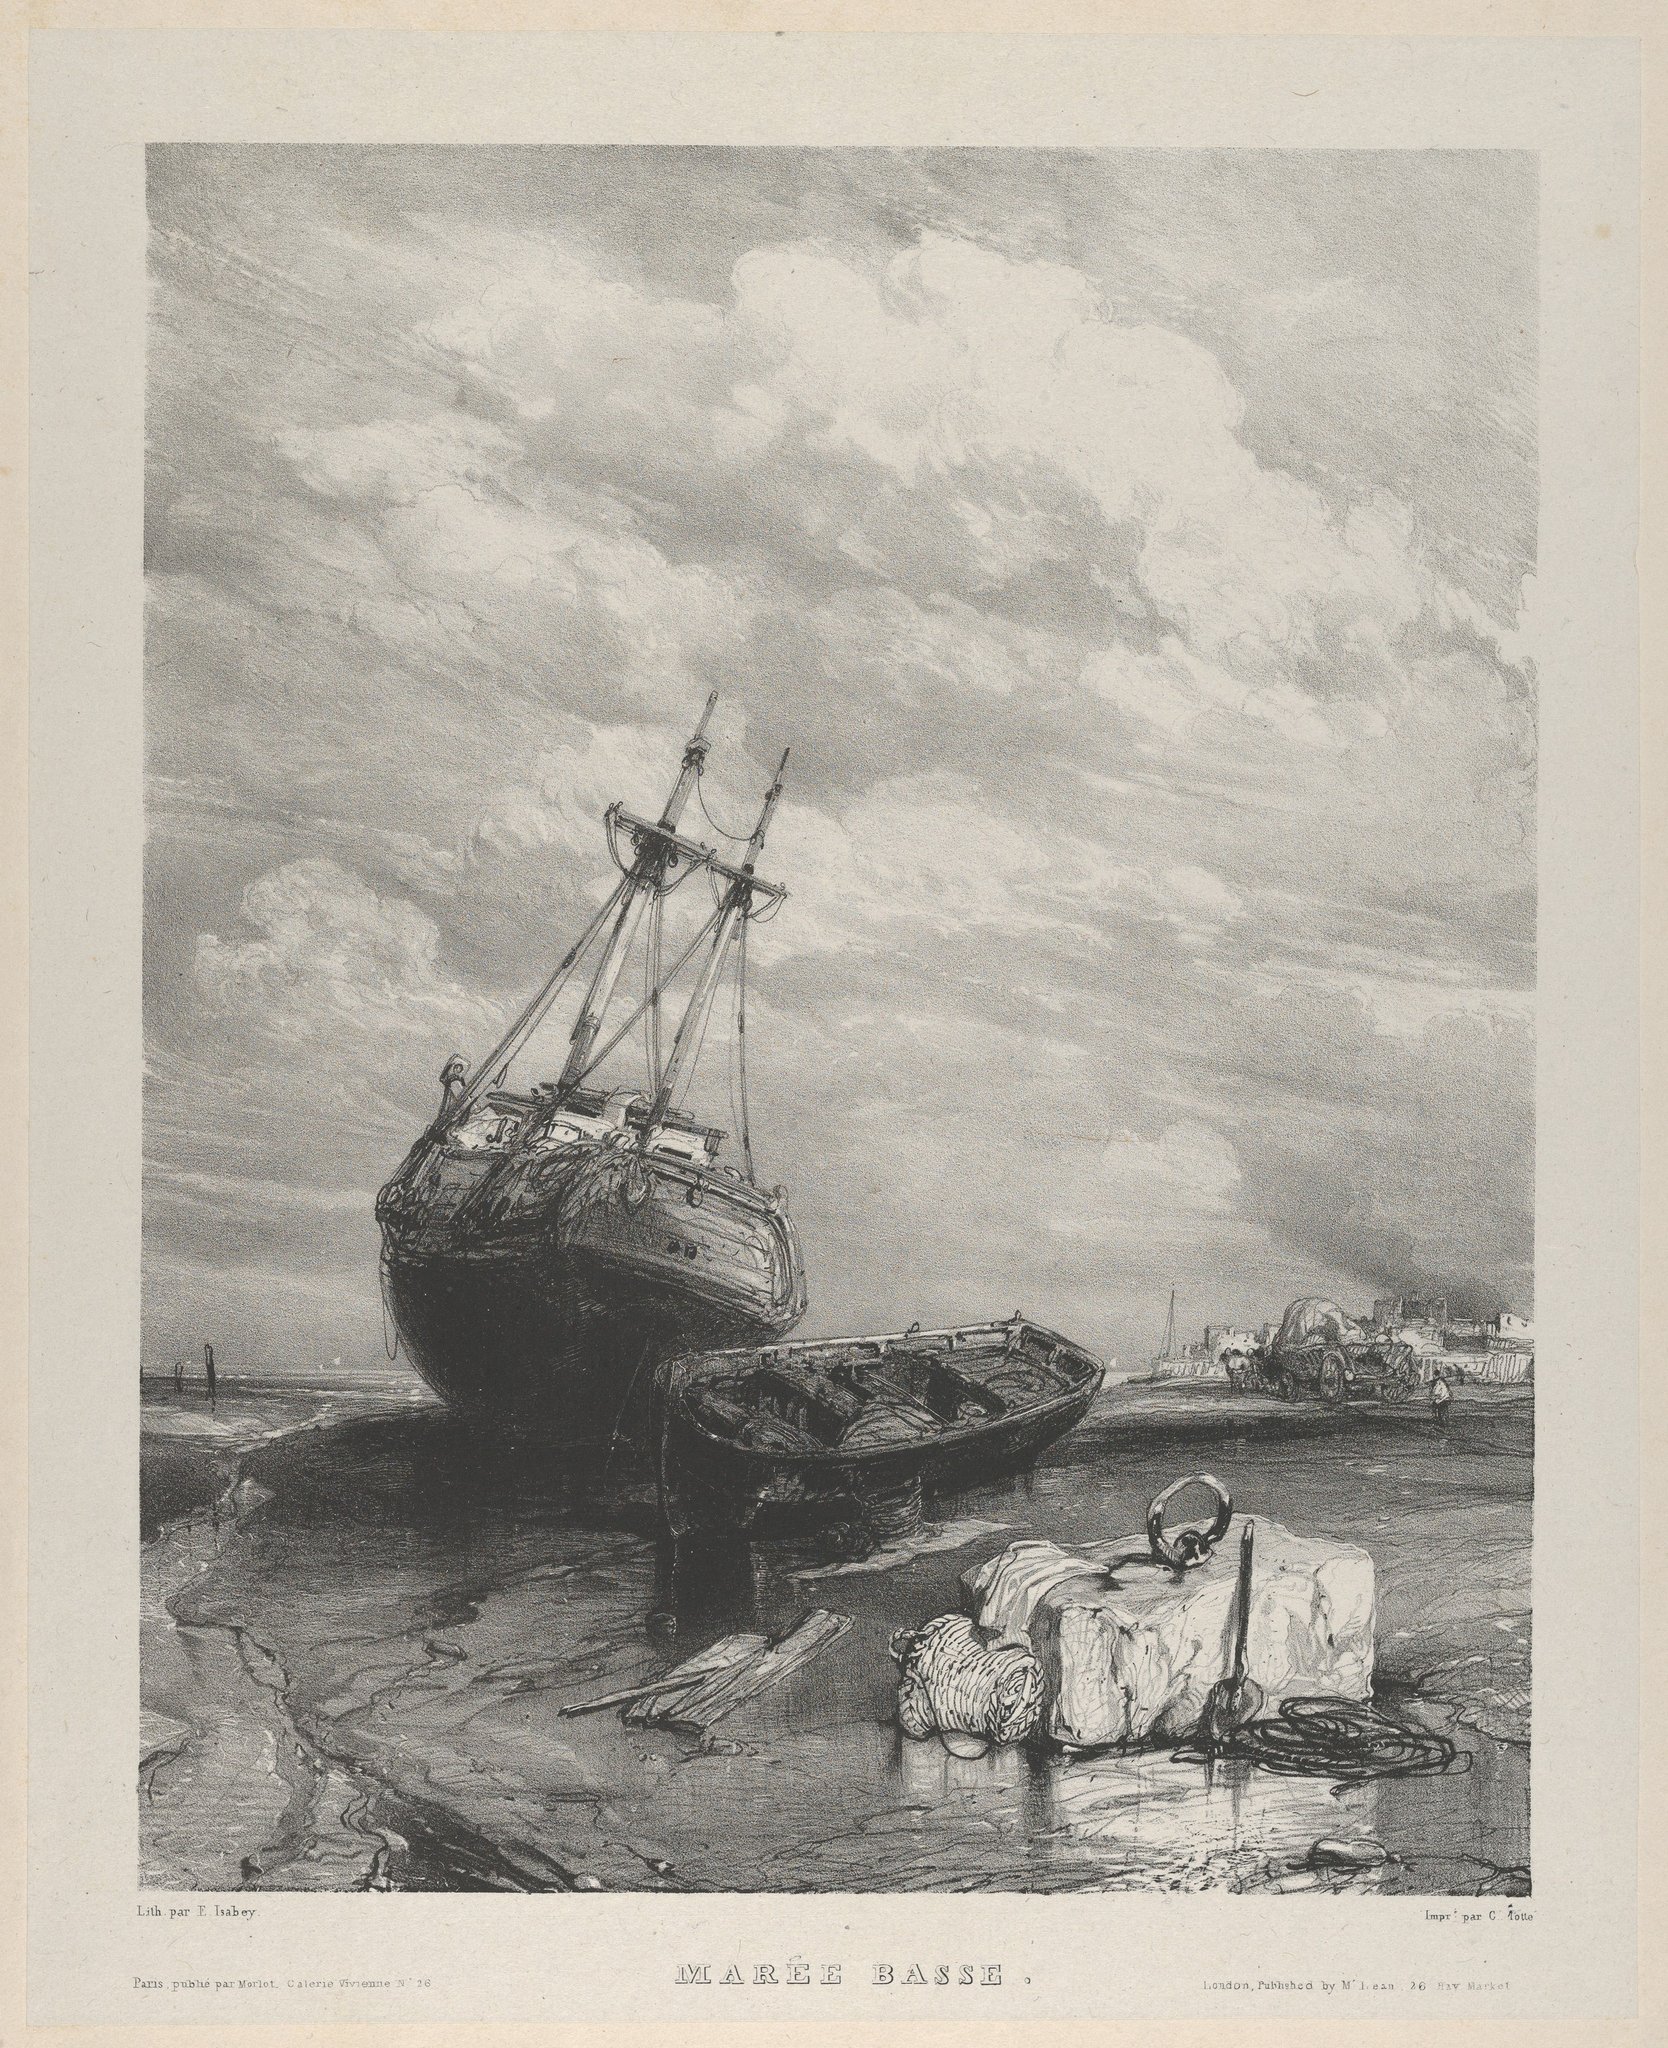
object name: print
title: Low Tide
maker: eugène isabey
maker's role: artist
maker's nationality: french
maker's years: 1803-1886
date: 1833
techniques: printmaking, lithograph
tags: boats,ships